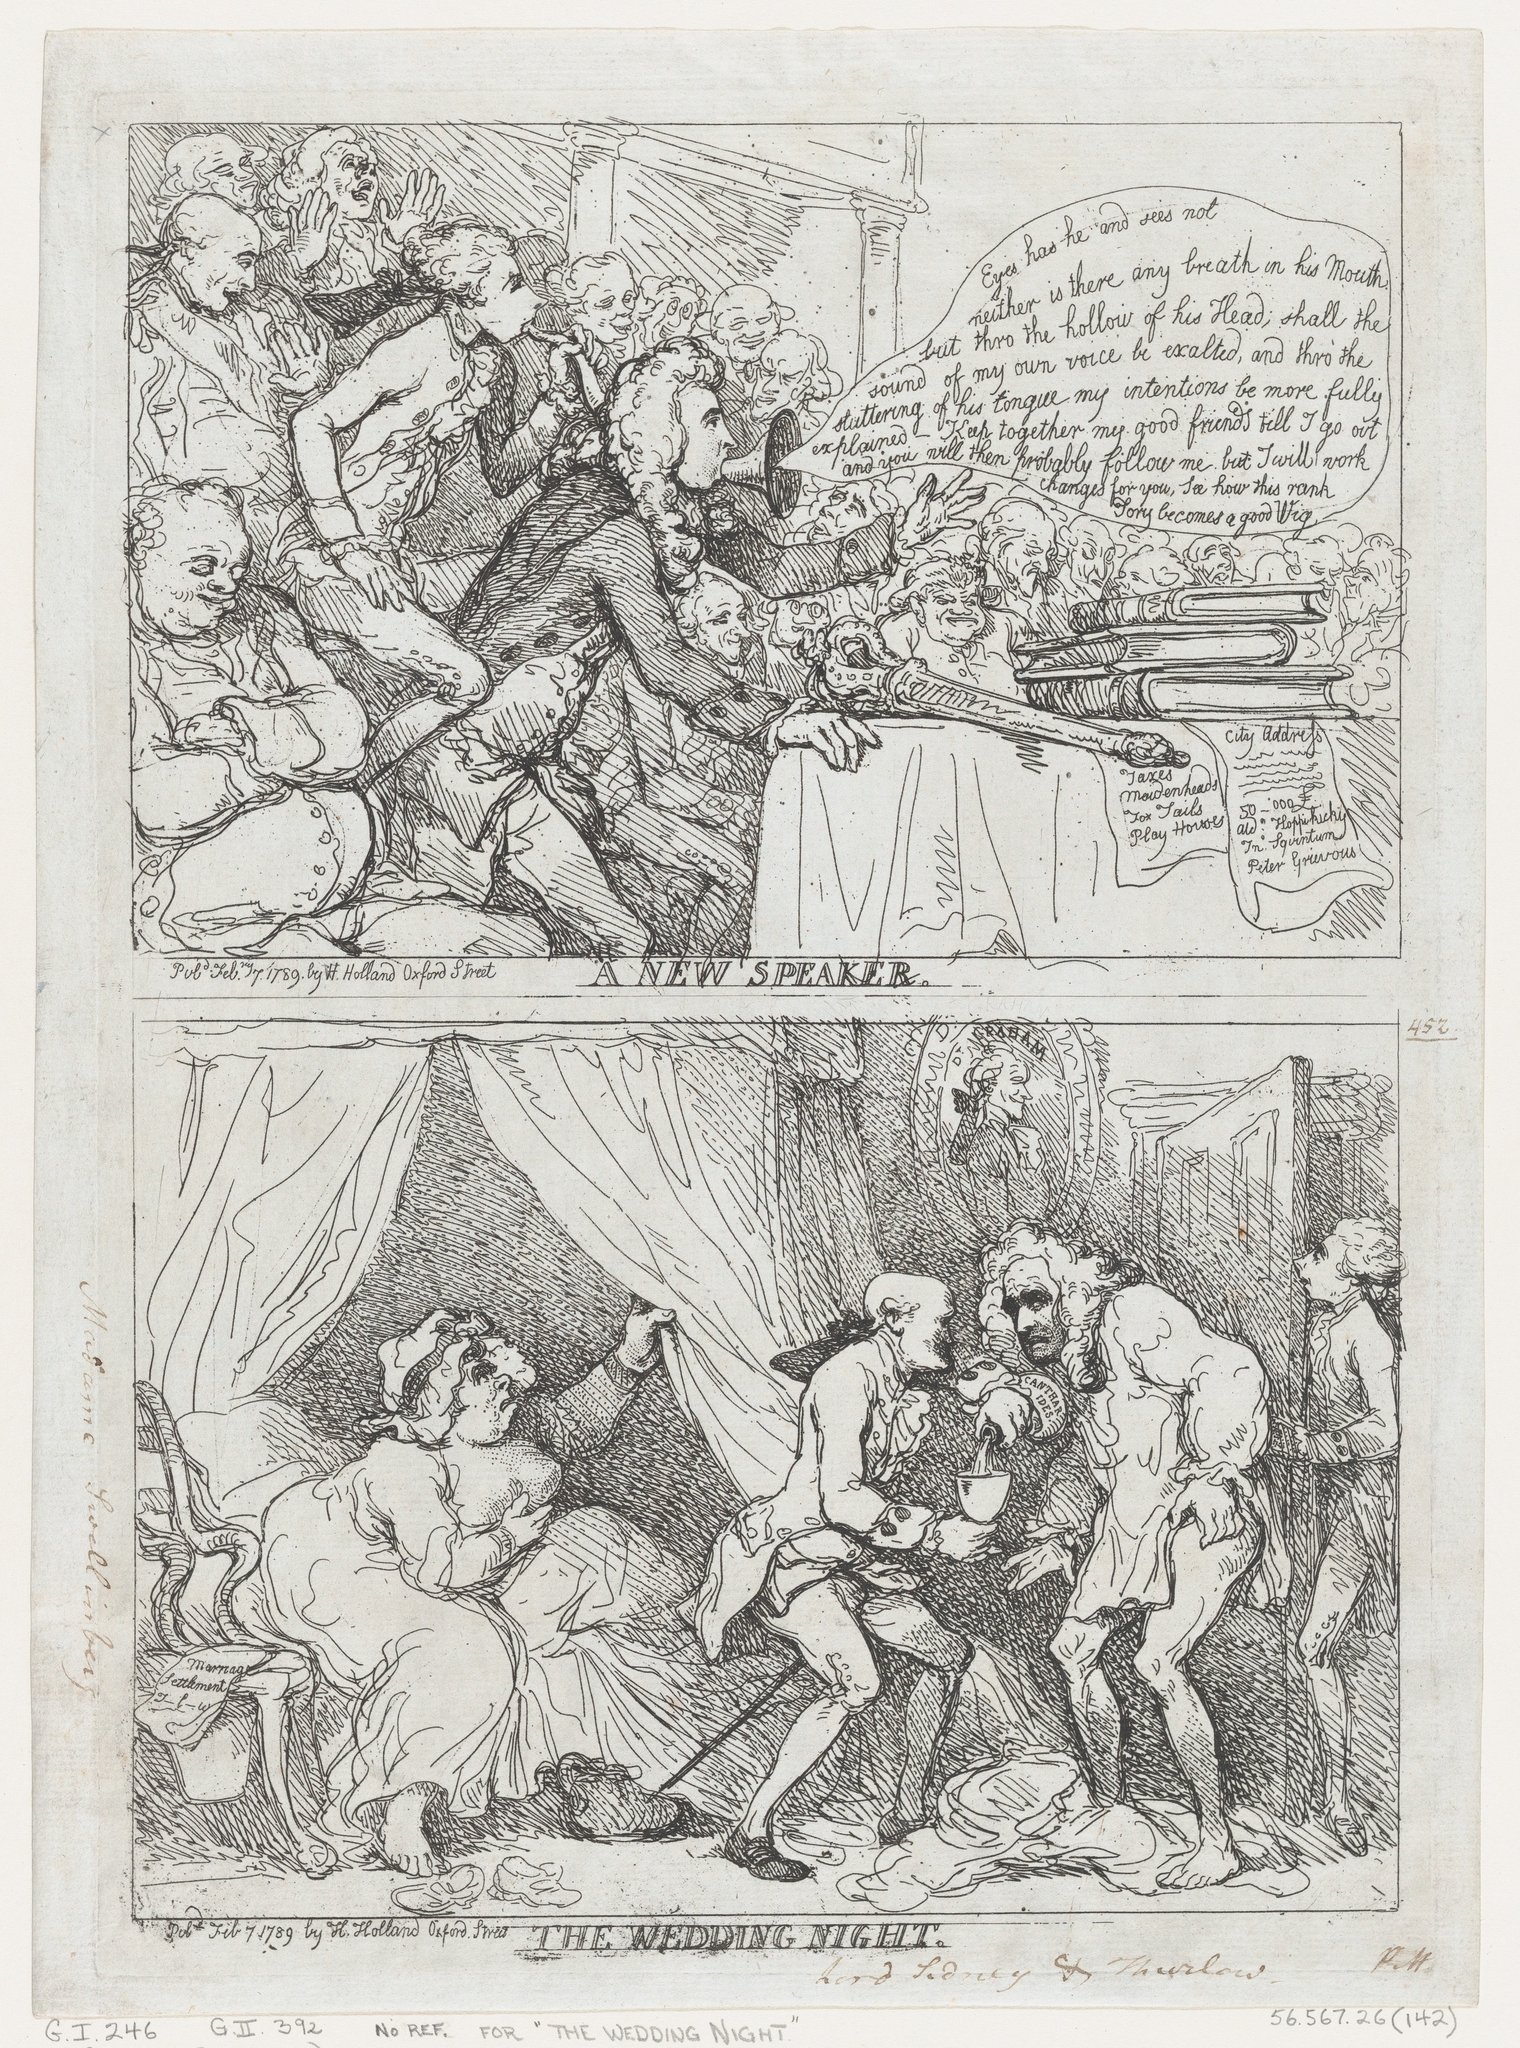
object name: print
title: A New Speaker and The Wedding Night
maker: thomas rowlandson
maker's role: artist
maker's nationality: british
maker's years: 1757-1827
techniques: etching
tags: satire,bedrooms,men,women